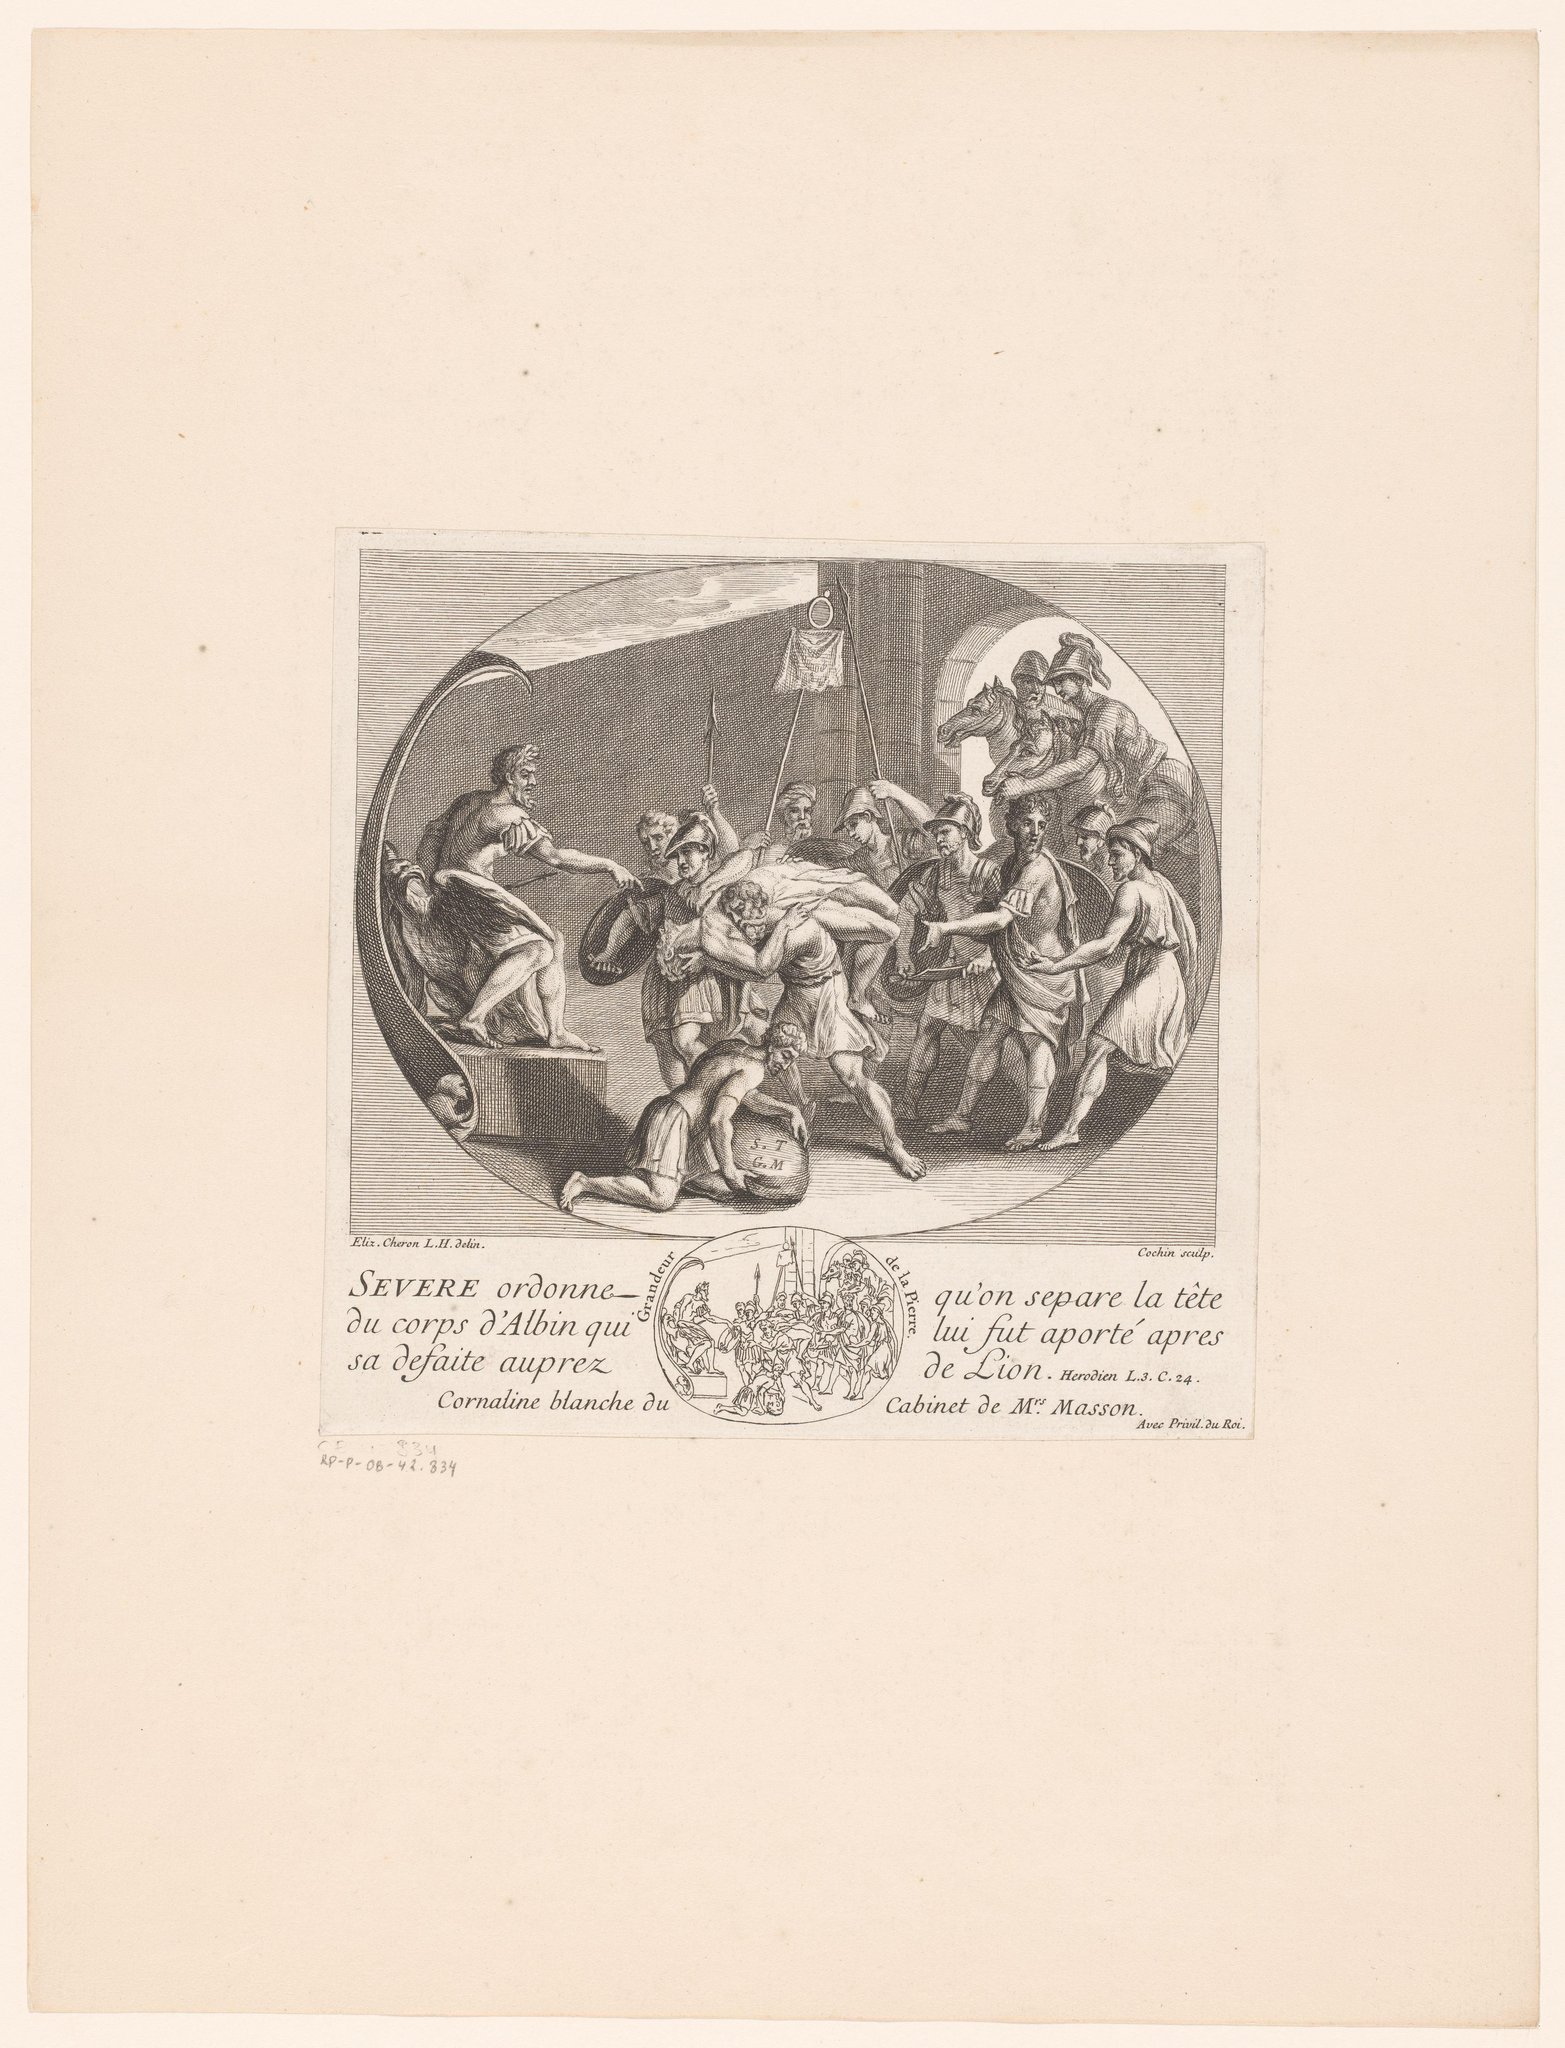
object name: print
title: Bevel tot onthoofding van Clodius Albinus door Septimus Severus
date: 1709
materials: paper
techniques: engraving, etching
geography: france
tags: soldiers and civilians, violent death by beheading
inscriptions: collector's mark: Lugt 2228